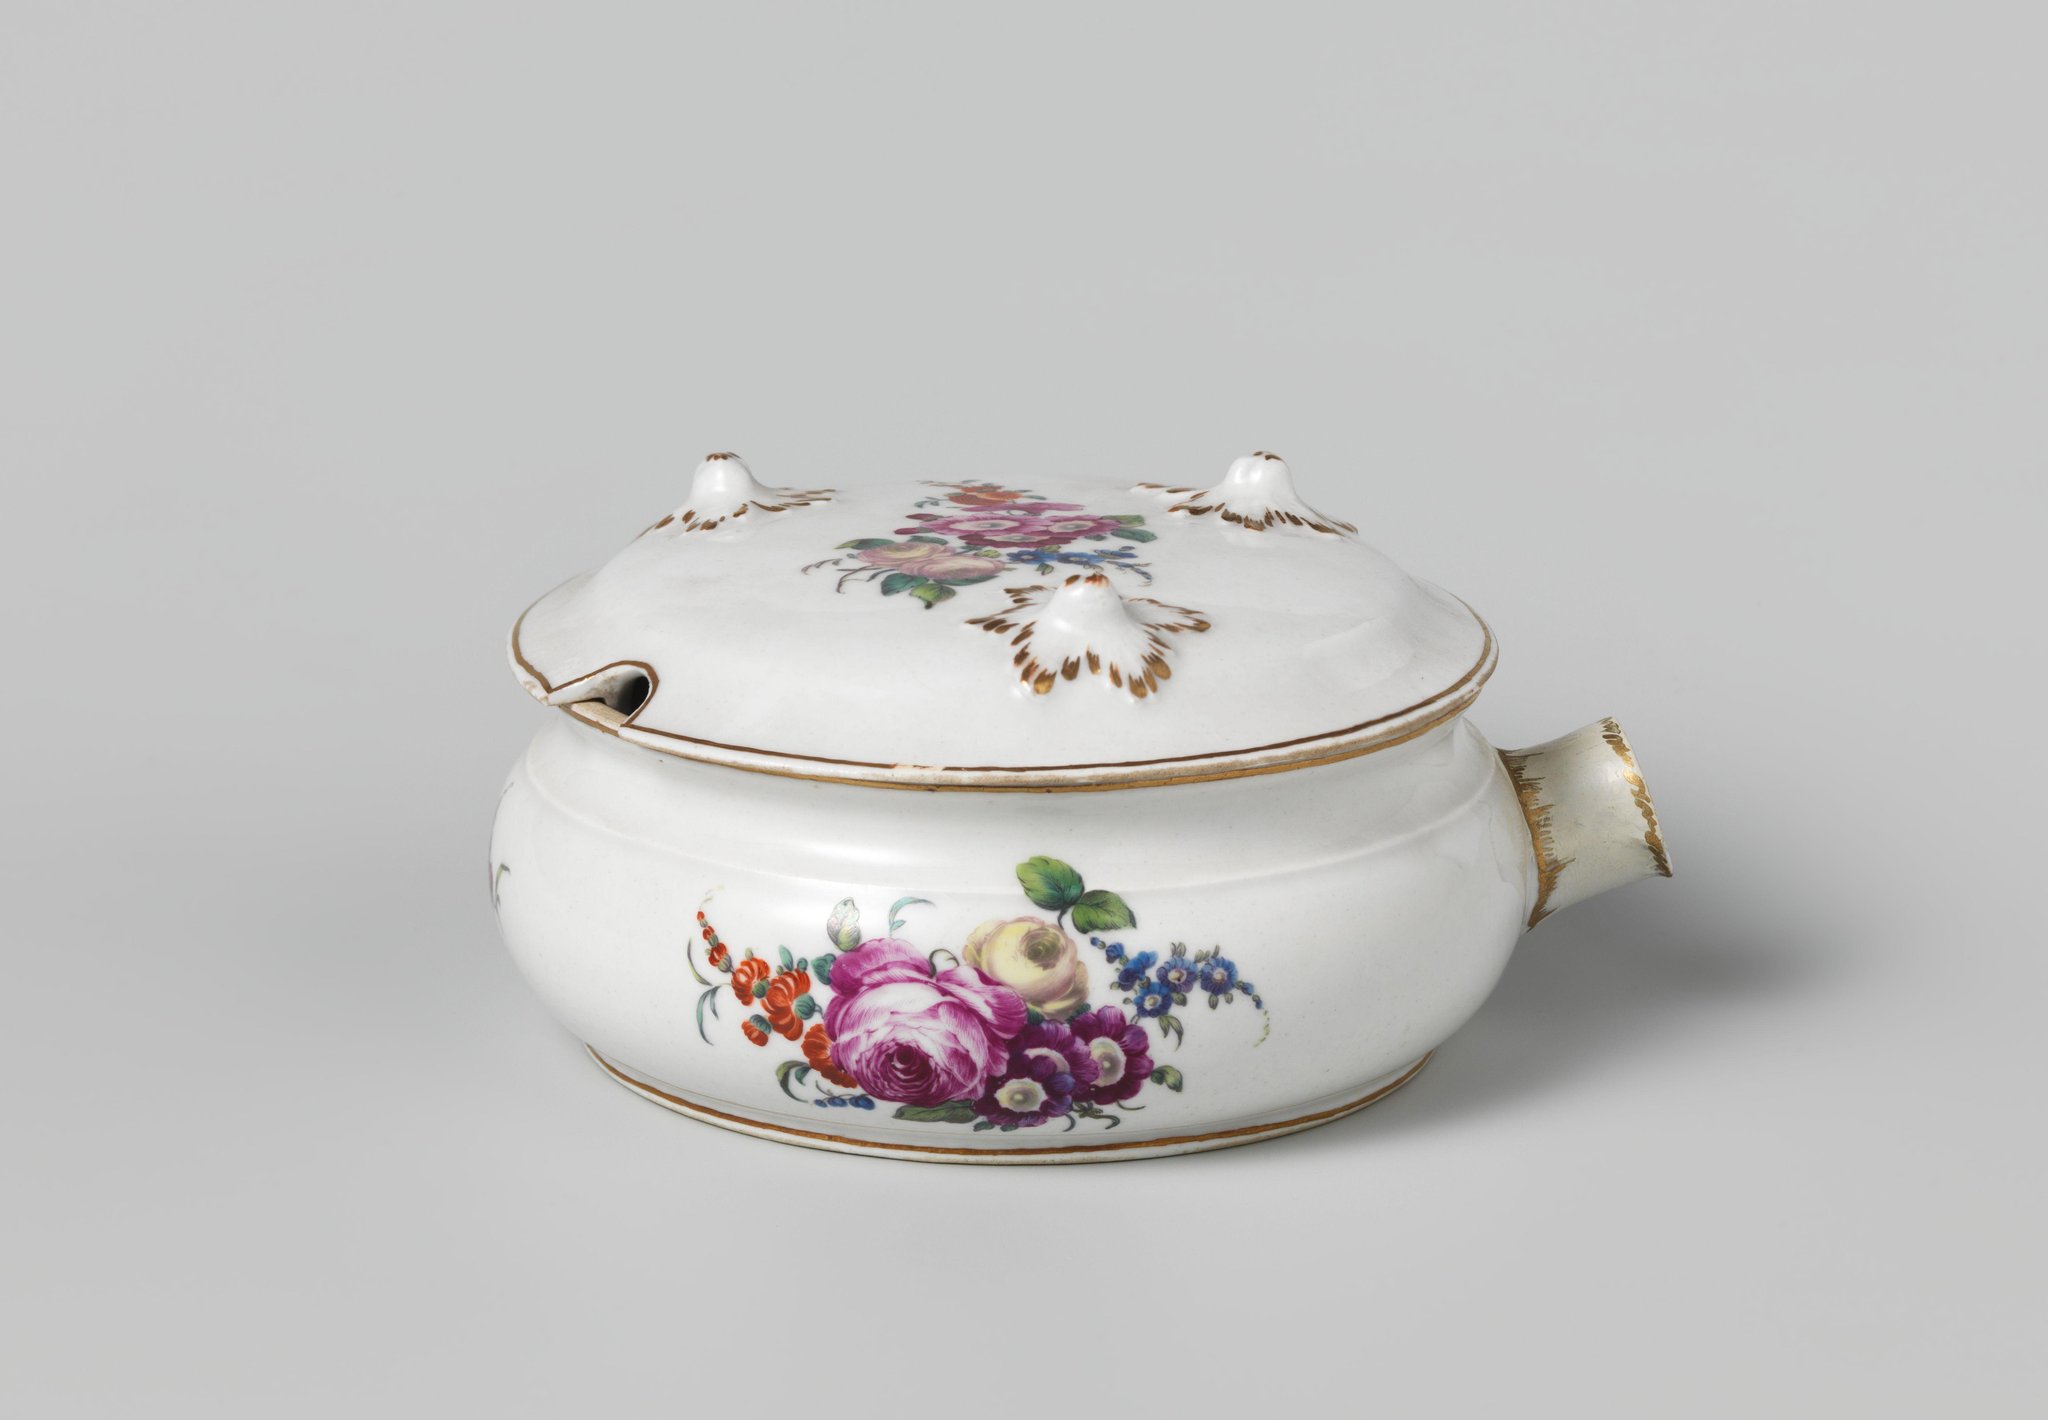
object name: lid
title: Deksel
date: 1774-1784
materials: porcelain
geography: loosdrecht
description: Op het deksel drie bloemen en relief met gouden omranding en een opening voor een lepel.